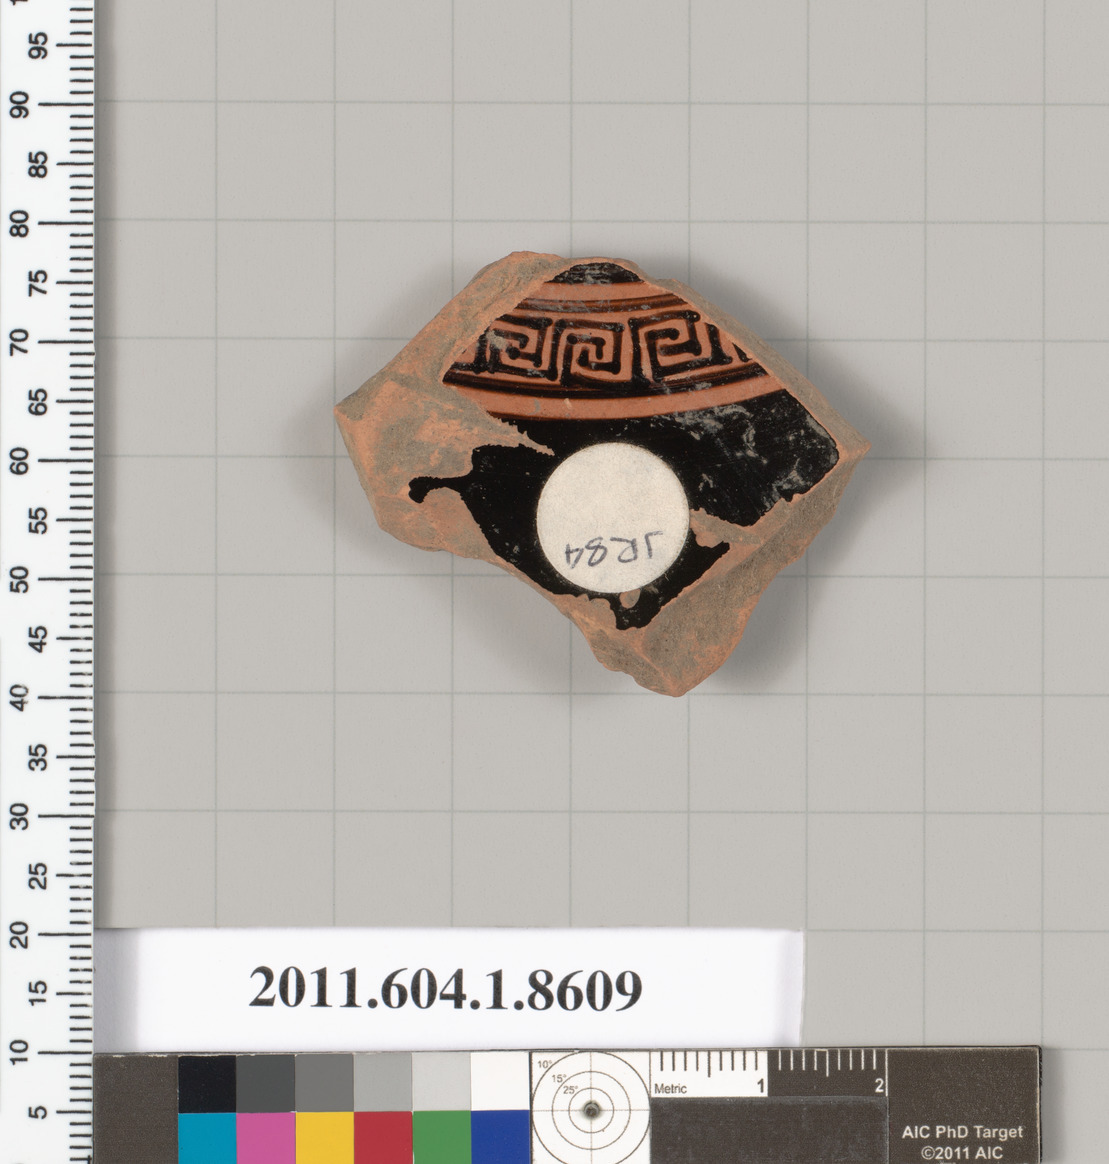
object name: kylix fragment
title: Terracotta fragment of a stemless kylix (drinking cup)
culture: greek, attic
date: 475-451 BCE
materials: terracotta